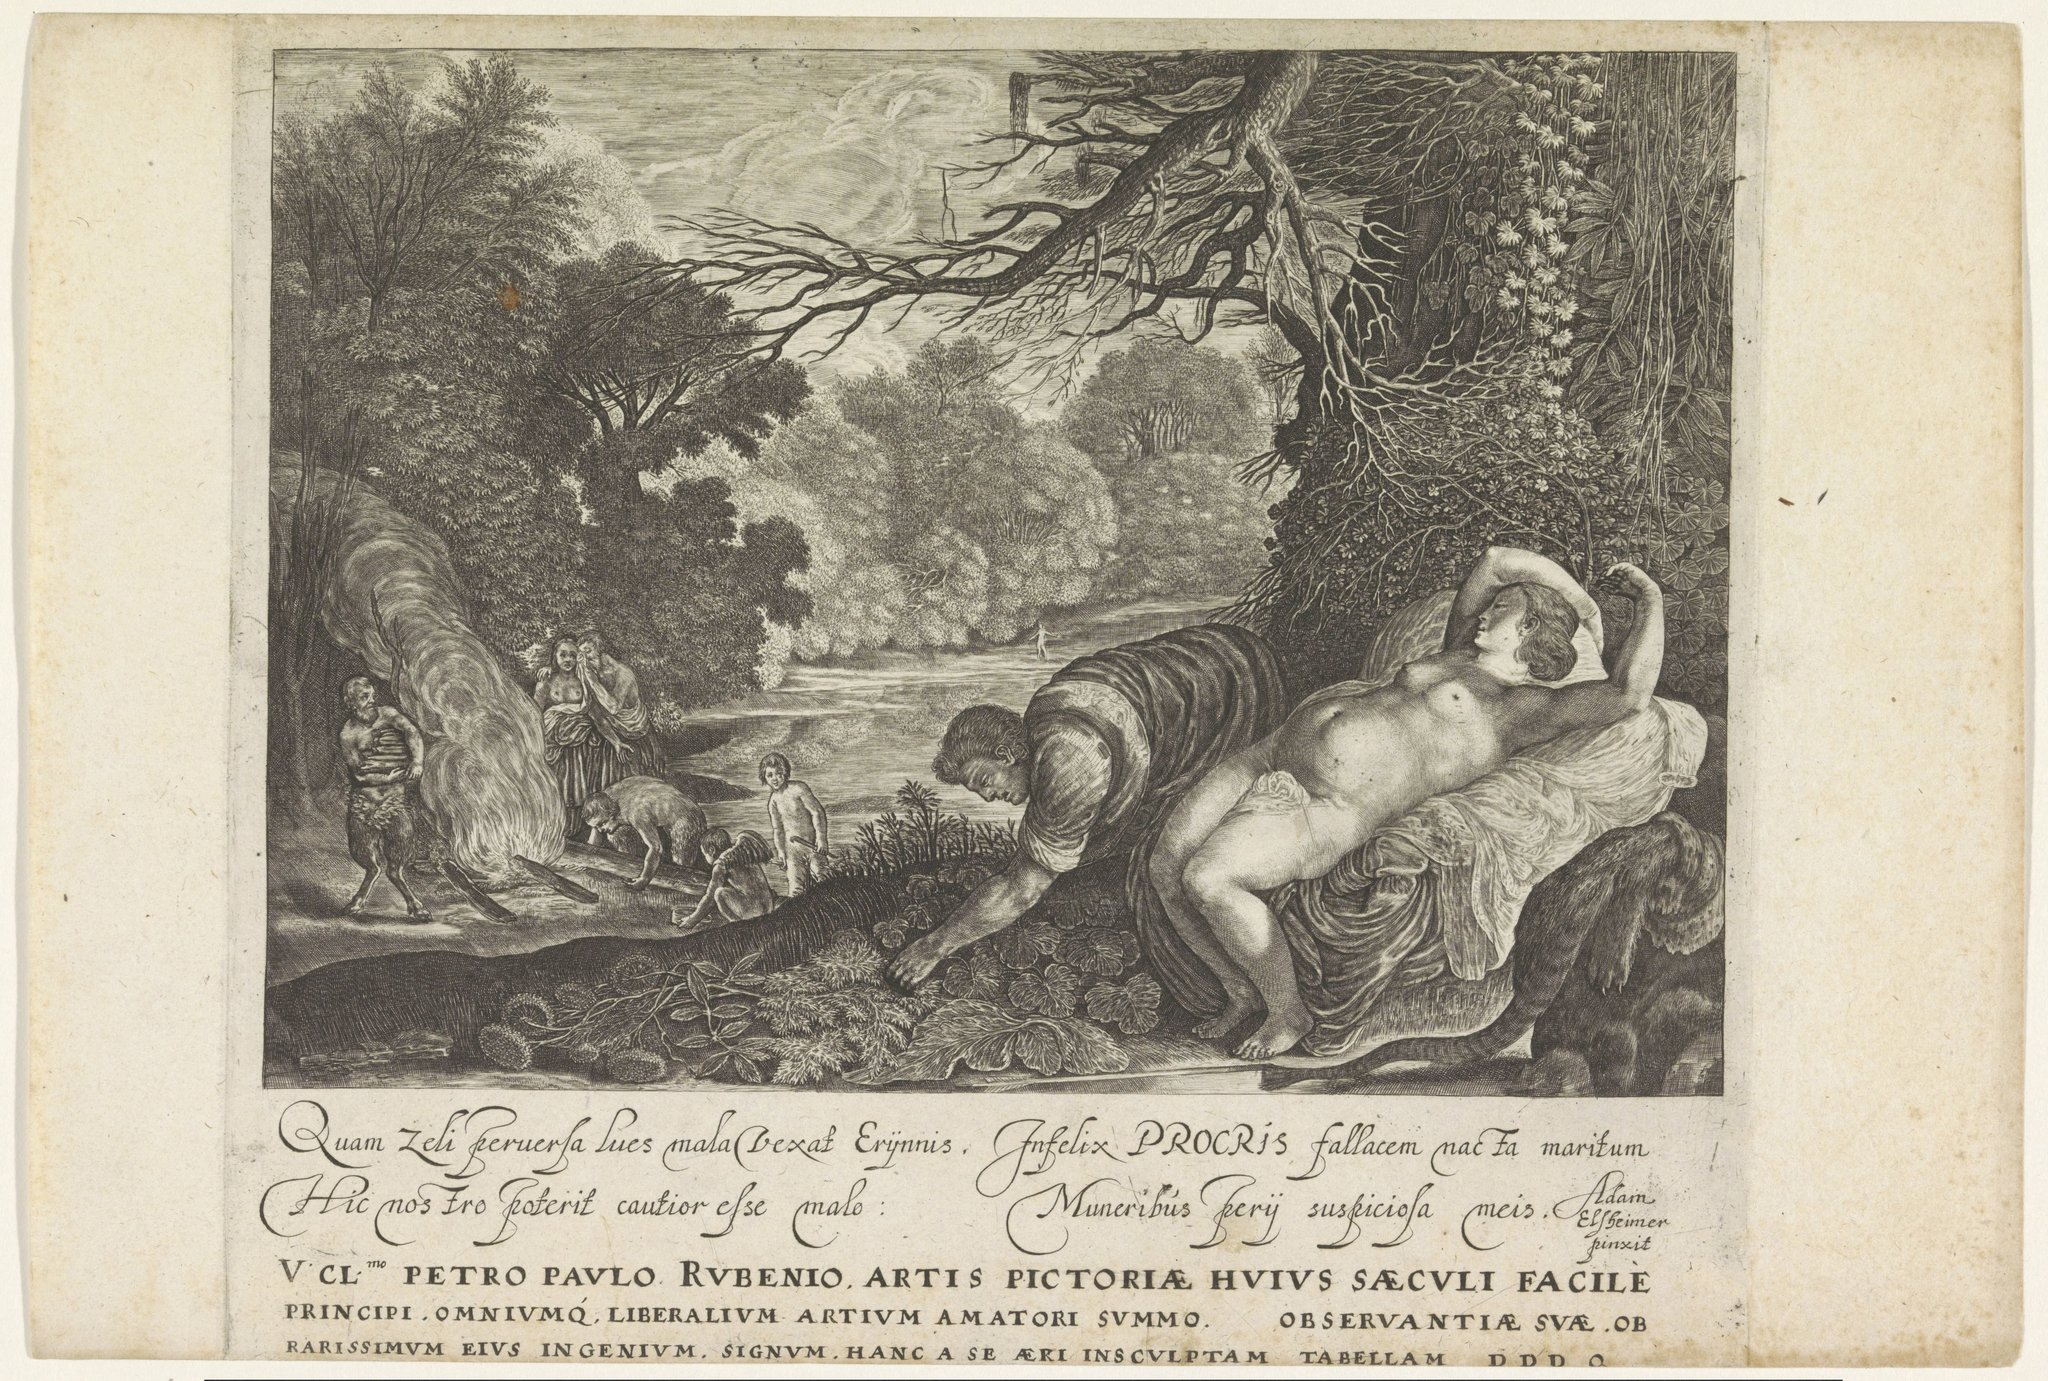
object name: print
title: Dood van Procris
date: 1636-1670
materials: paper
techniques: engraving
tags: mourning of procris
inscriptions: collector's mark: ‘Hinloopen’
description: Het schilderij van Elsheimer, daar getiteld 'Apollo en Coronis', bevindt zich in de Walker Art Gallery te Liverpool. Deze incomplete serie, bestaande uit 77 van de in totaal 85 prenten met scènes uit Ovidius' Metamorfosen, werd in 1709 samen met Ovidius-illustraties van Tempesta, Goltzius en Le Pautre in één album, Schijnvoet nummer 43, ingebonden. In de negentiende eeuw werd deze band weer uit elkaar gehaald.